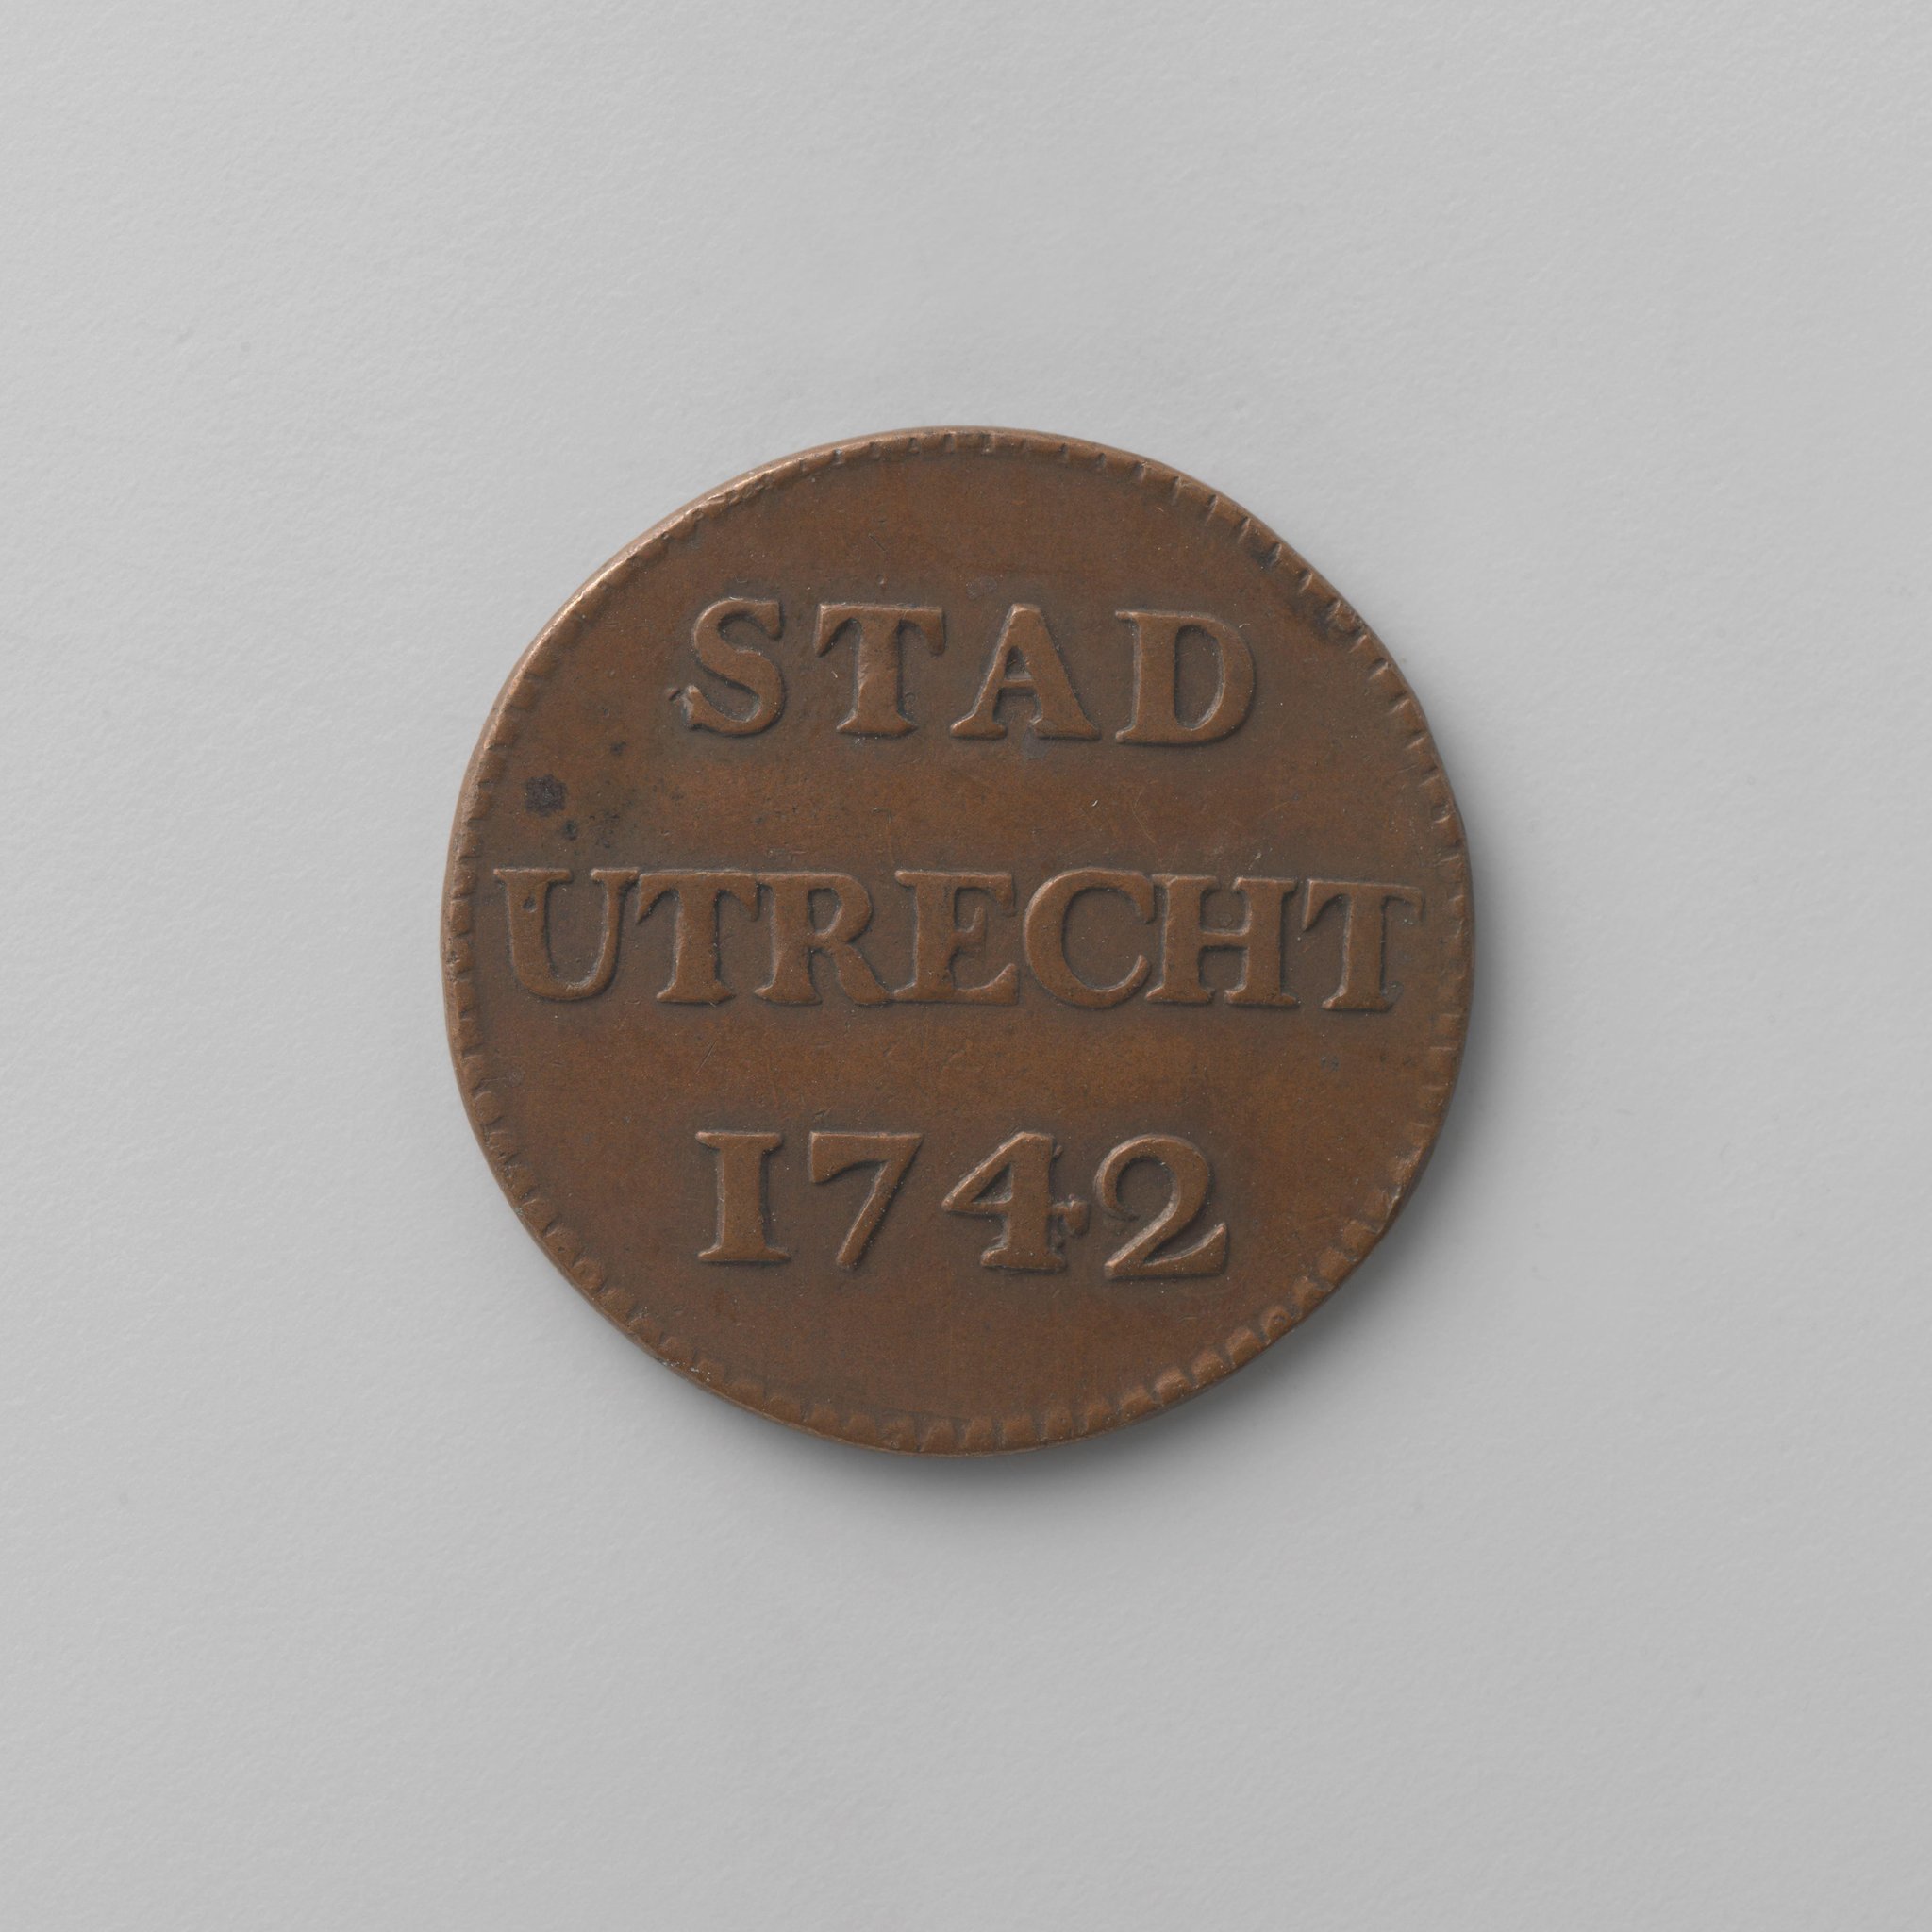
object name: coin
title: Duit van de stad Utrecht, 1742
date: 1742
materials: copper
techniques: striking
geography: utrecht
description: Koperen munt. Voorzijde: gekroond stedelijk wapenschild, gehouden door twee leeuwen met in afsnede dunne lijn, waaronder een versierde accolade met een grote schelp. Keerzijde: opschrift in twee regels, waaronder jaartal. Jaartal met Romeinse I.